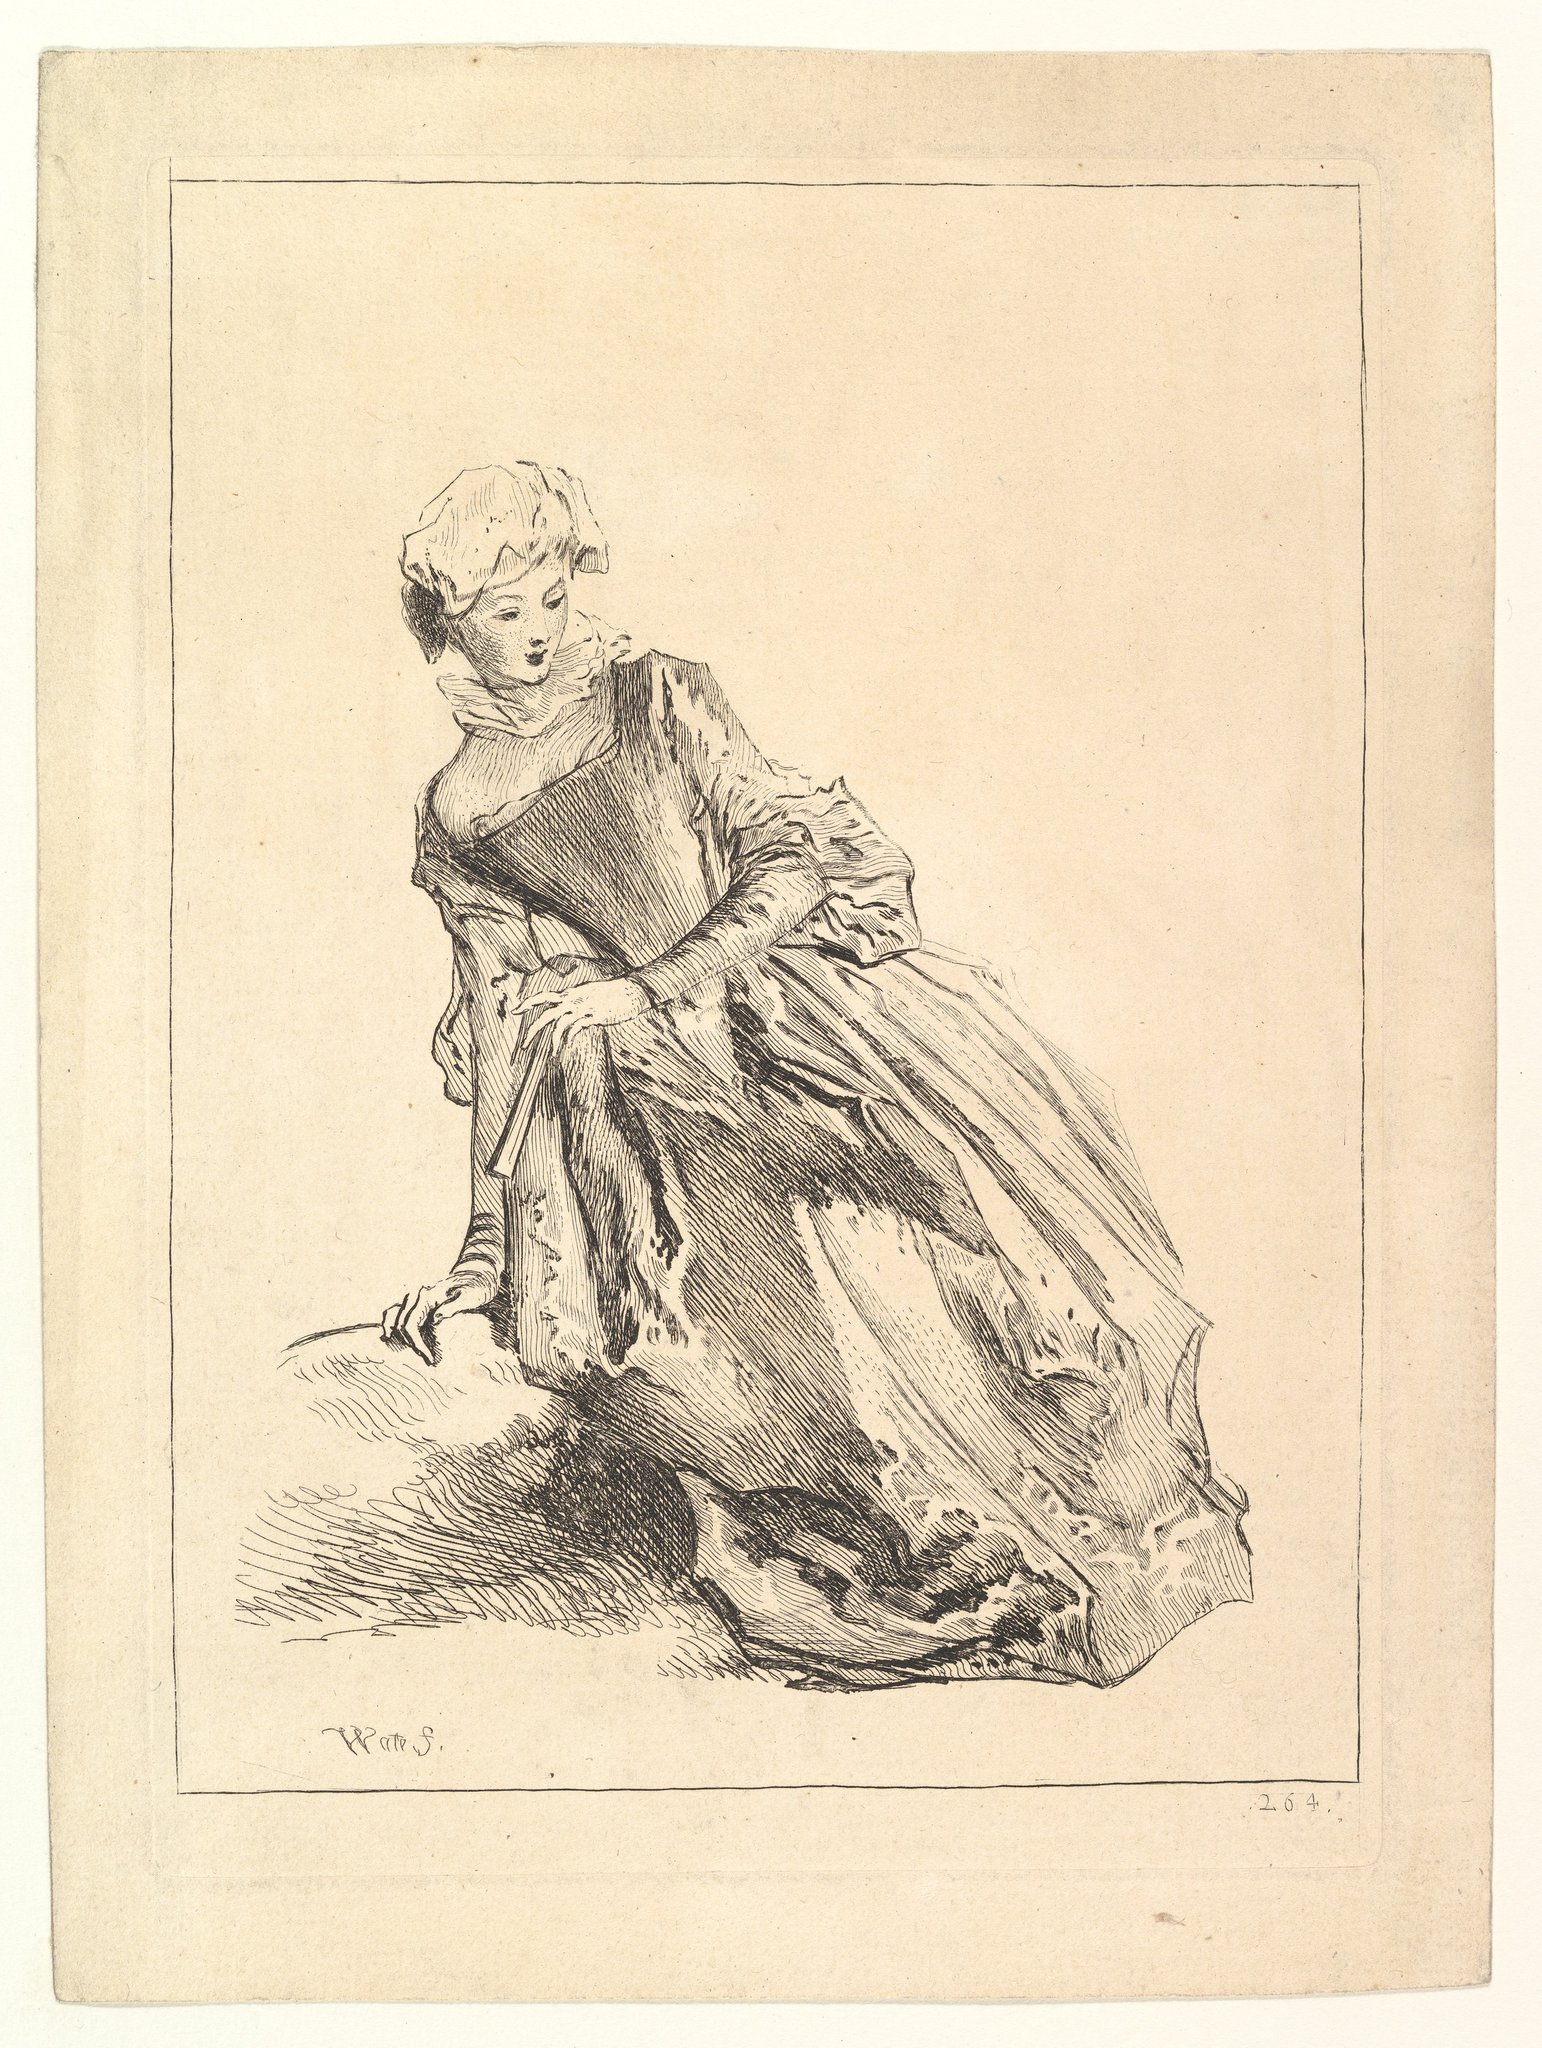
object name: print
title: Woman leaning to left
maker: françois boucher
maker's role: artist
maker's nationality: french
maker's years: 1703-1770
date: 1722-1728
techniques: etching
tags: women